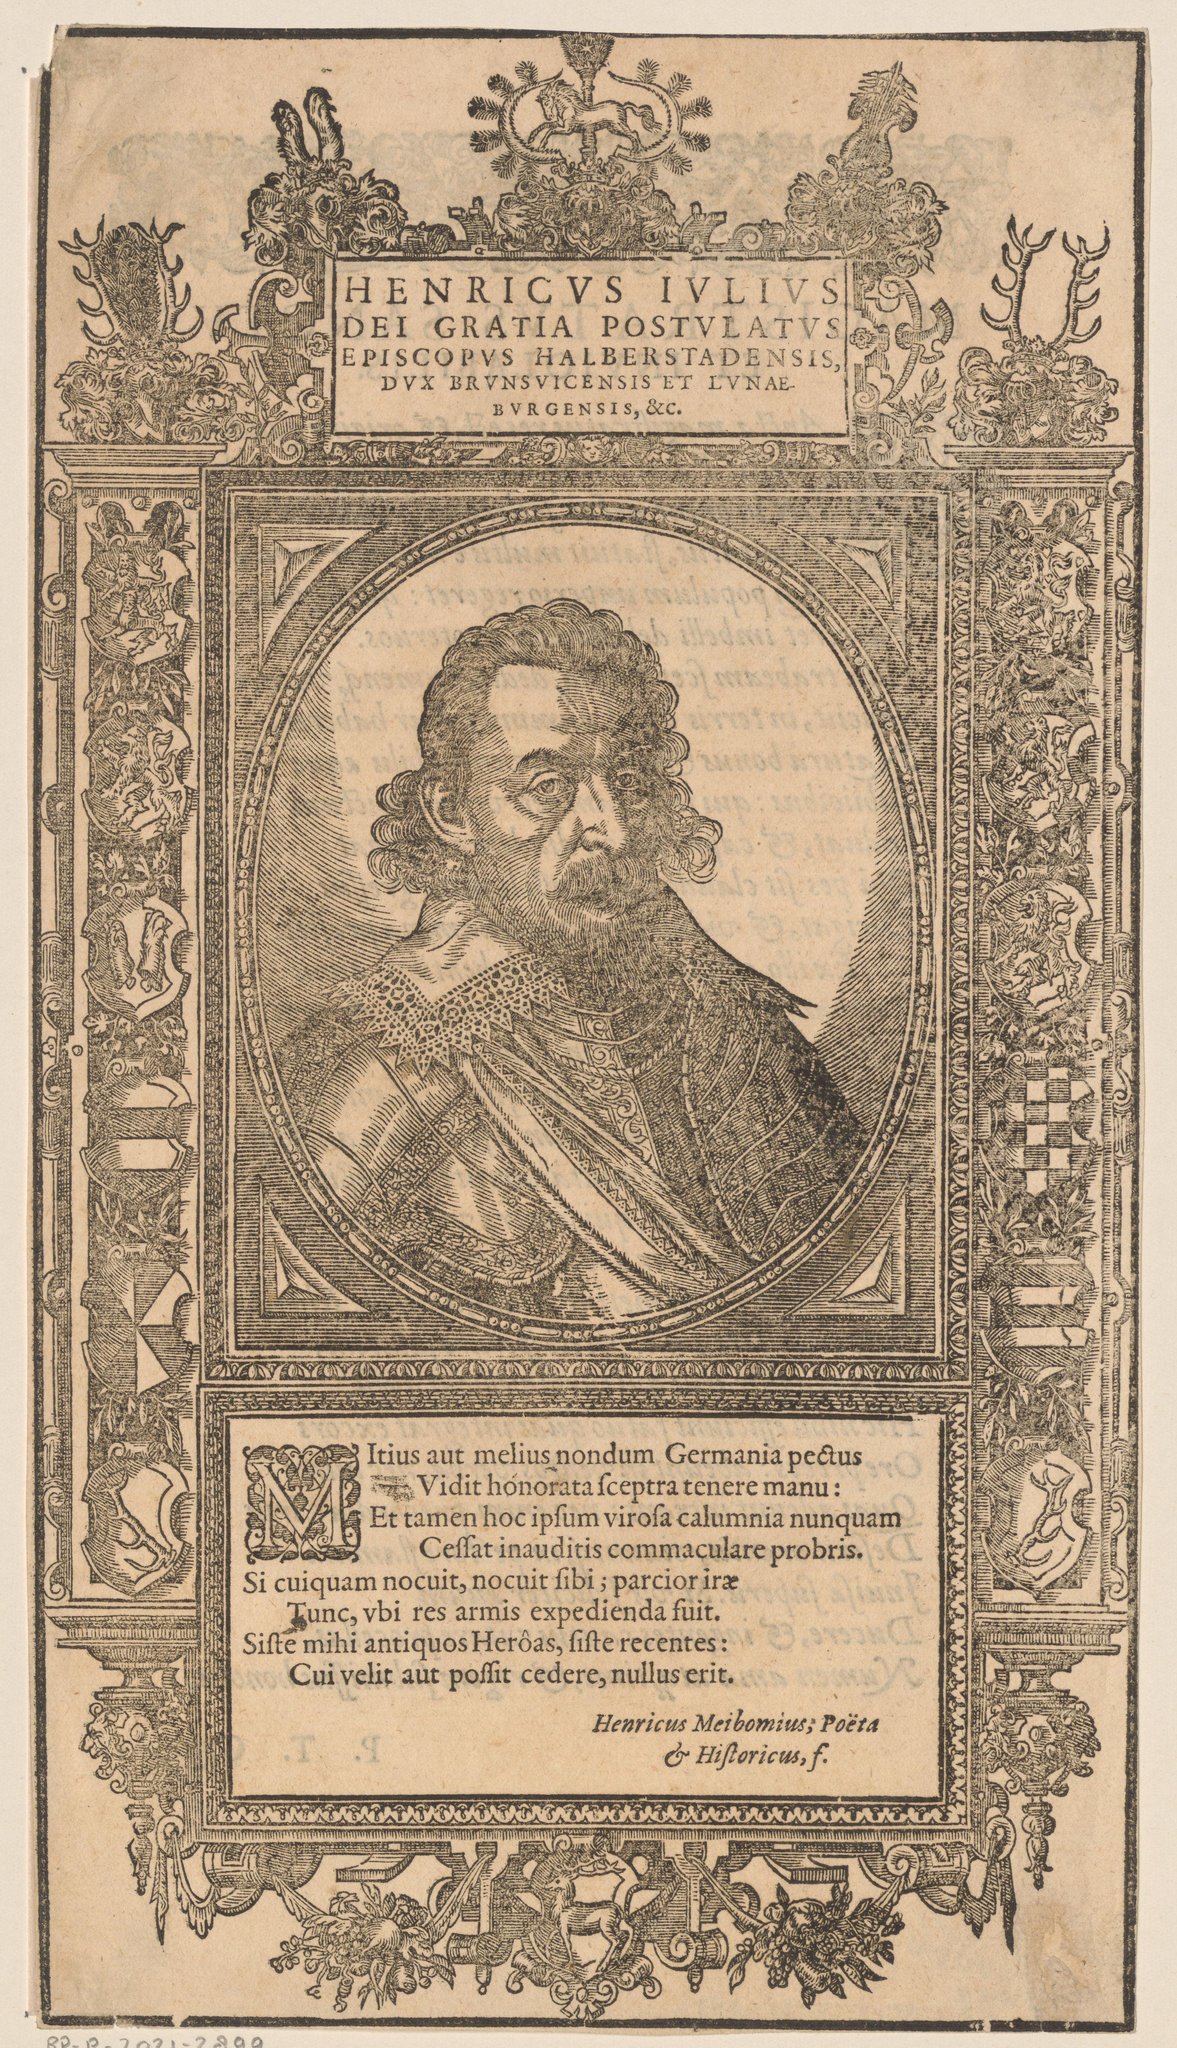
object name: book illustration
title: Portret van Hendrik Julius van Brunswijk-Wolffenbüttel, bisschop van Halberstadt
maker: Anonymous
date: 1607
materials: paper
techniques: letterpress printing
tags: armour, historical persons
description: Prent uit: Meibom, Heinrich. Aussführlicher Warhaffter Historischer Bericht, die Fürstliche Land: und Erbstadt Braunschweig (...). Helmstadt: s.n., 1607.